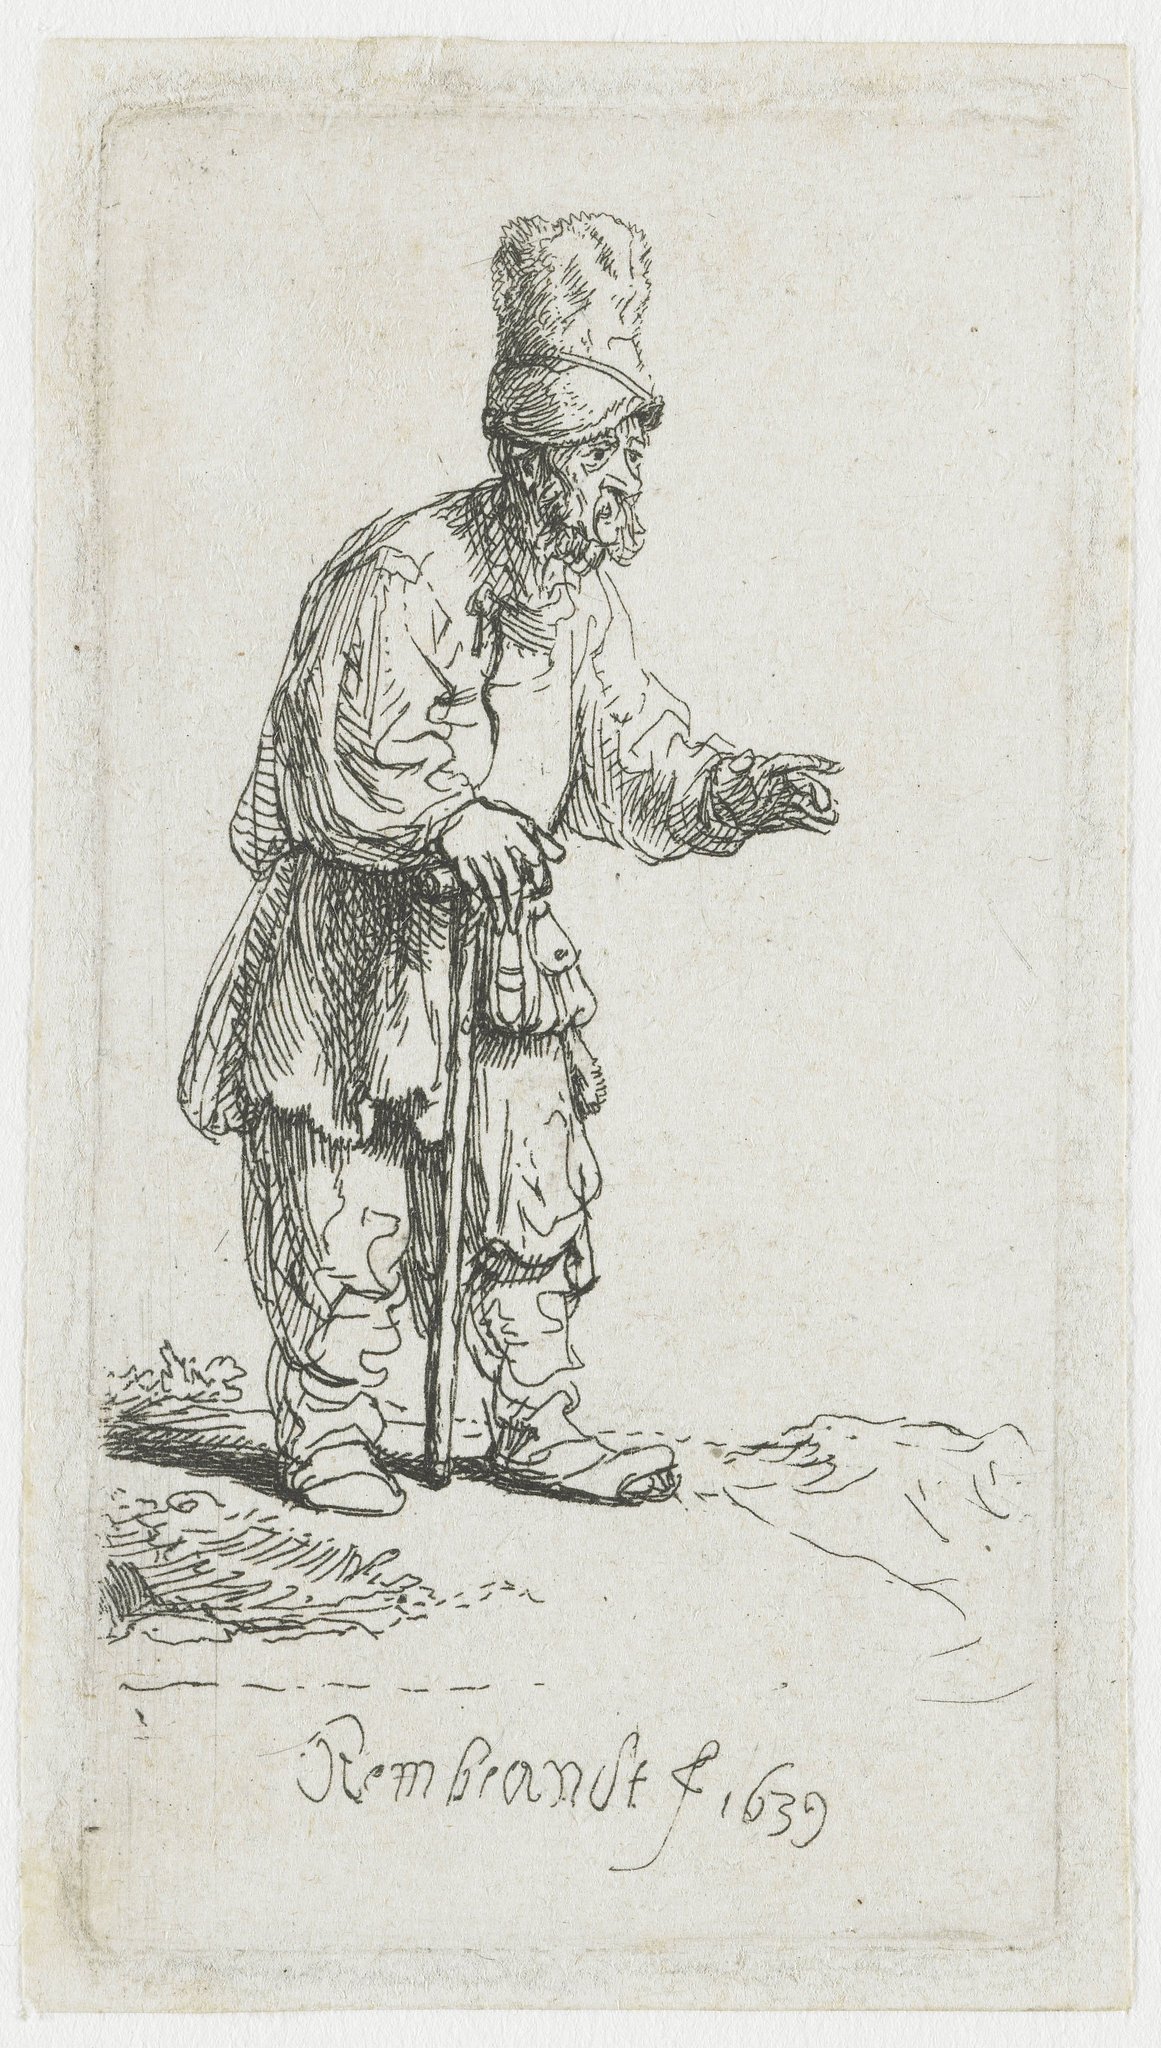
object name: print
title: A peasant in a high cap, standing leaning on a stick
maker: rembrandt van rijn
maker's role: draughtsman, painter, print maker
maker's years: 1606-1669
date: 1639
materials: paper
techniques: etching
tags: the ages of man (+ old male (human being))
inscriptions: mark: Lugt 654, signature and date: ‘Rembrandt f. 1639’ Lugt, mark: Lugt 2228, mark: 533 b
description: Rembrandt etched the largest of these three beggars in exactly the same style as the figures in the adjacent drawings. He indicated all of the shadows with vertical parallel lines. This hatching adds verve to the depiction, but is also somewhat coarse. In the two other etchings, he achieved a more refined result using the same style in a much smaller format.